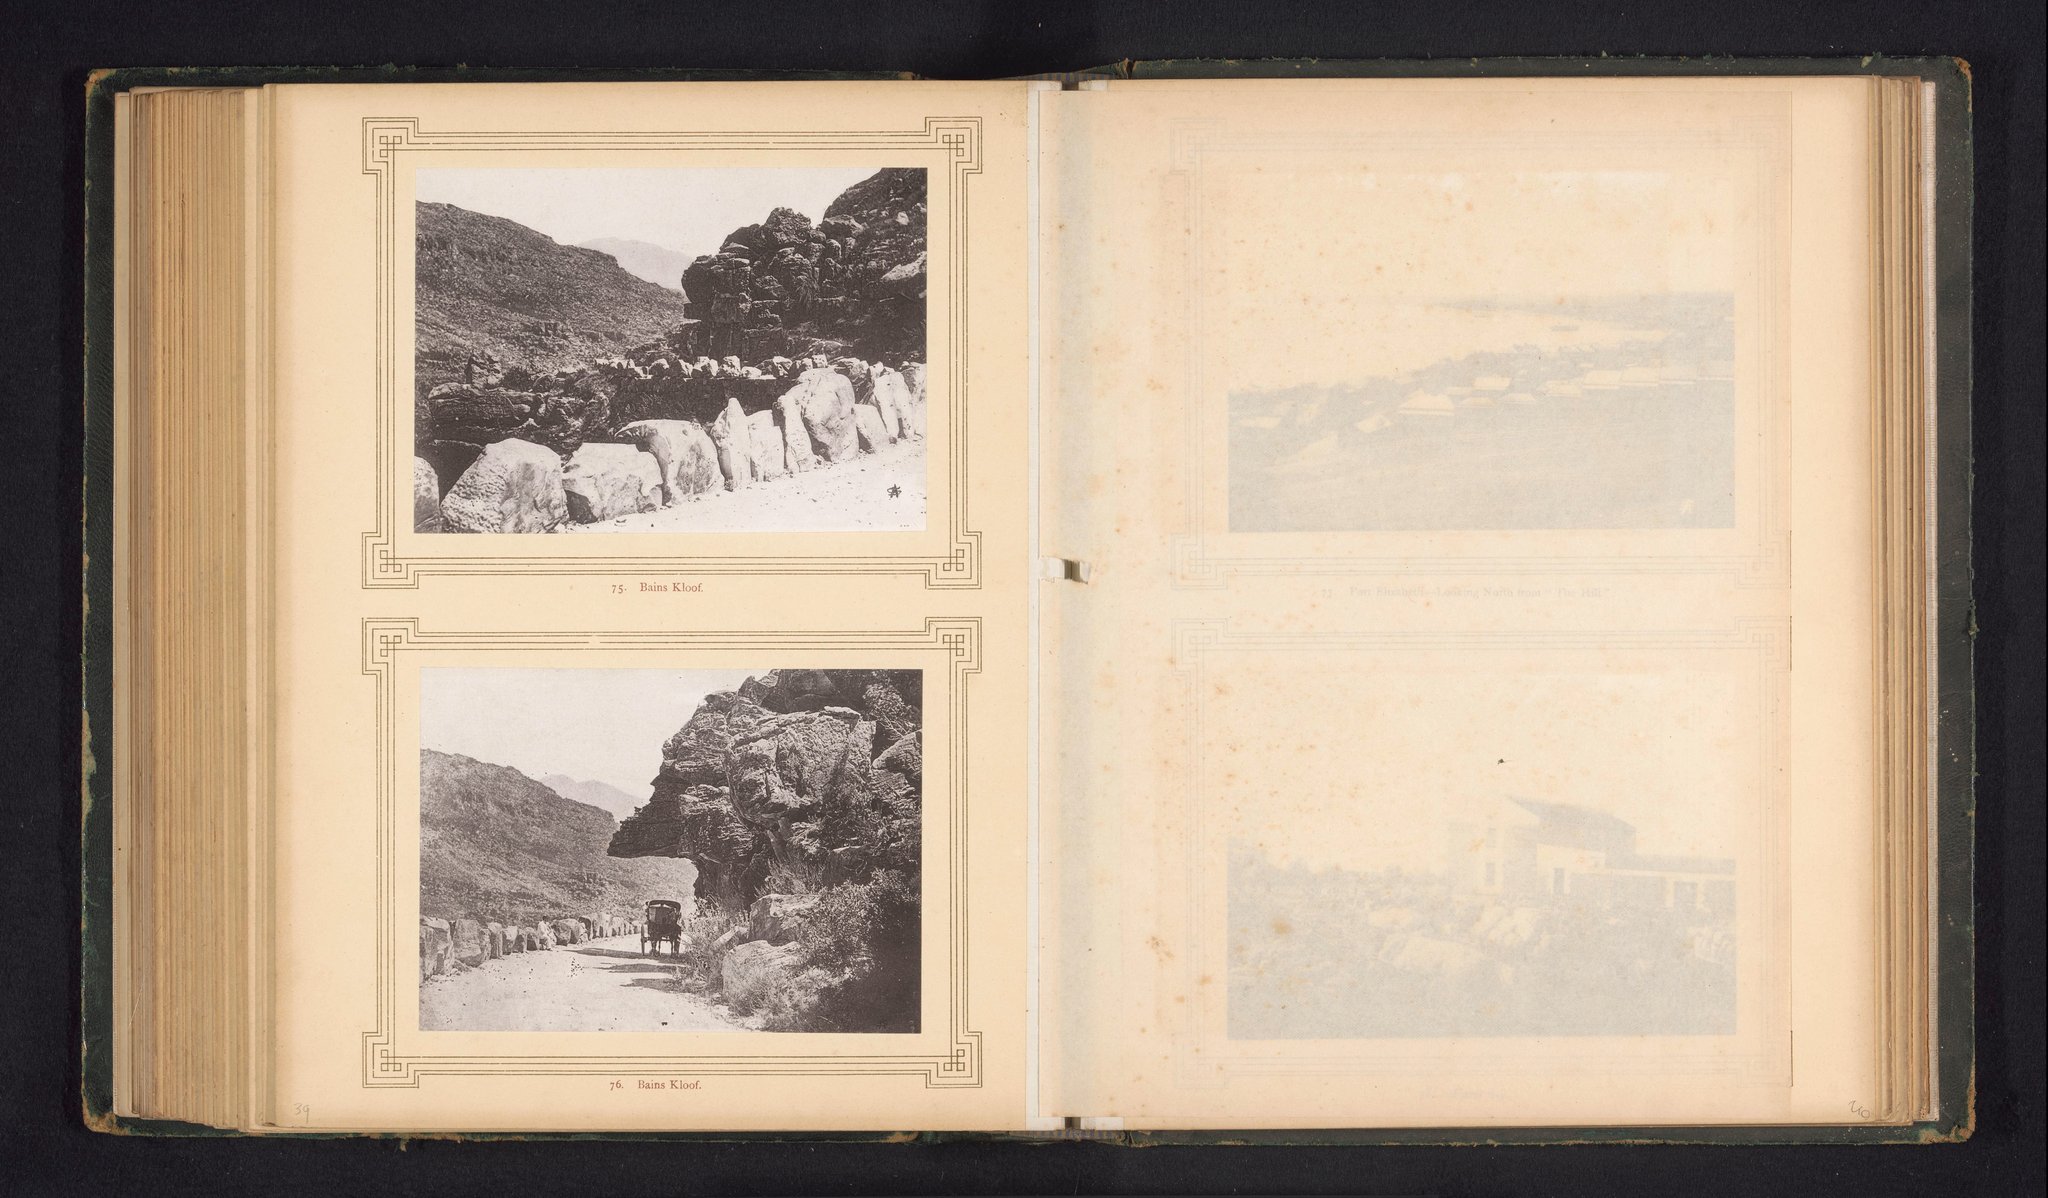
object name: photomechanical print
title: Bains Kloof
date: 1870-1880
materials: paper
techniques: photograph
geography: south africa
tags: dale, valley, public road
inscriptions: inscription: ‘SA’, number: ‘75. 76.’